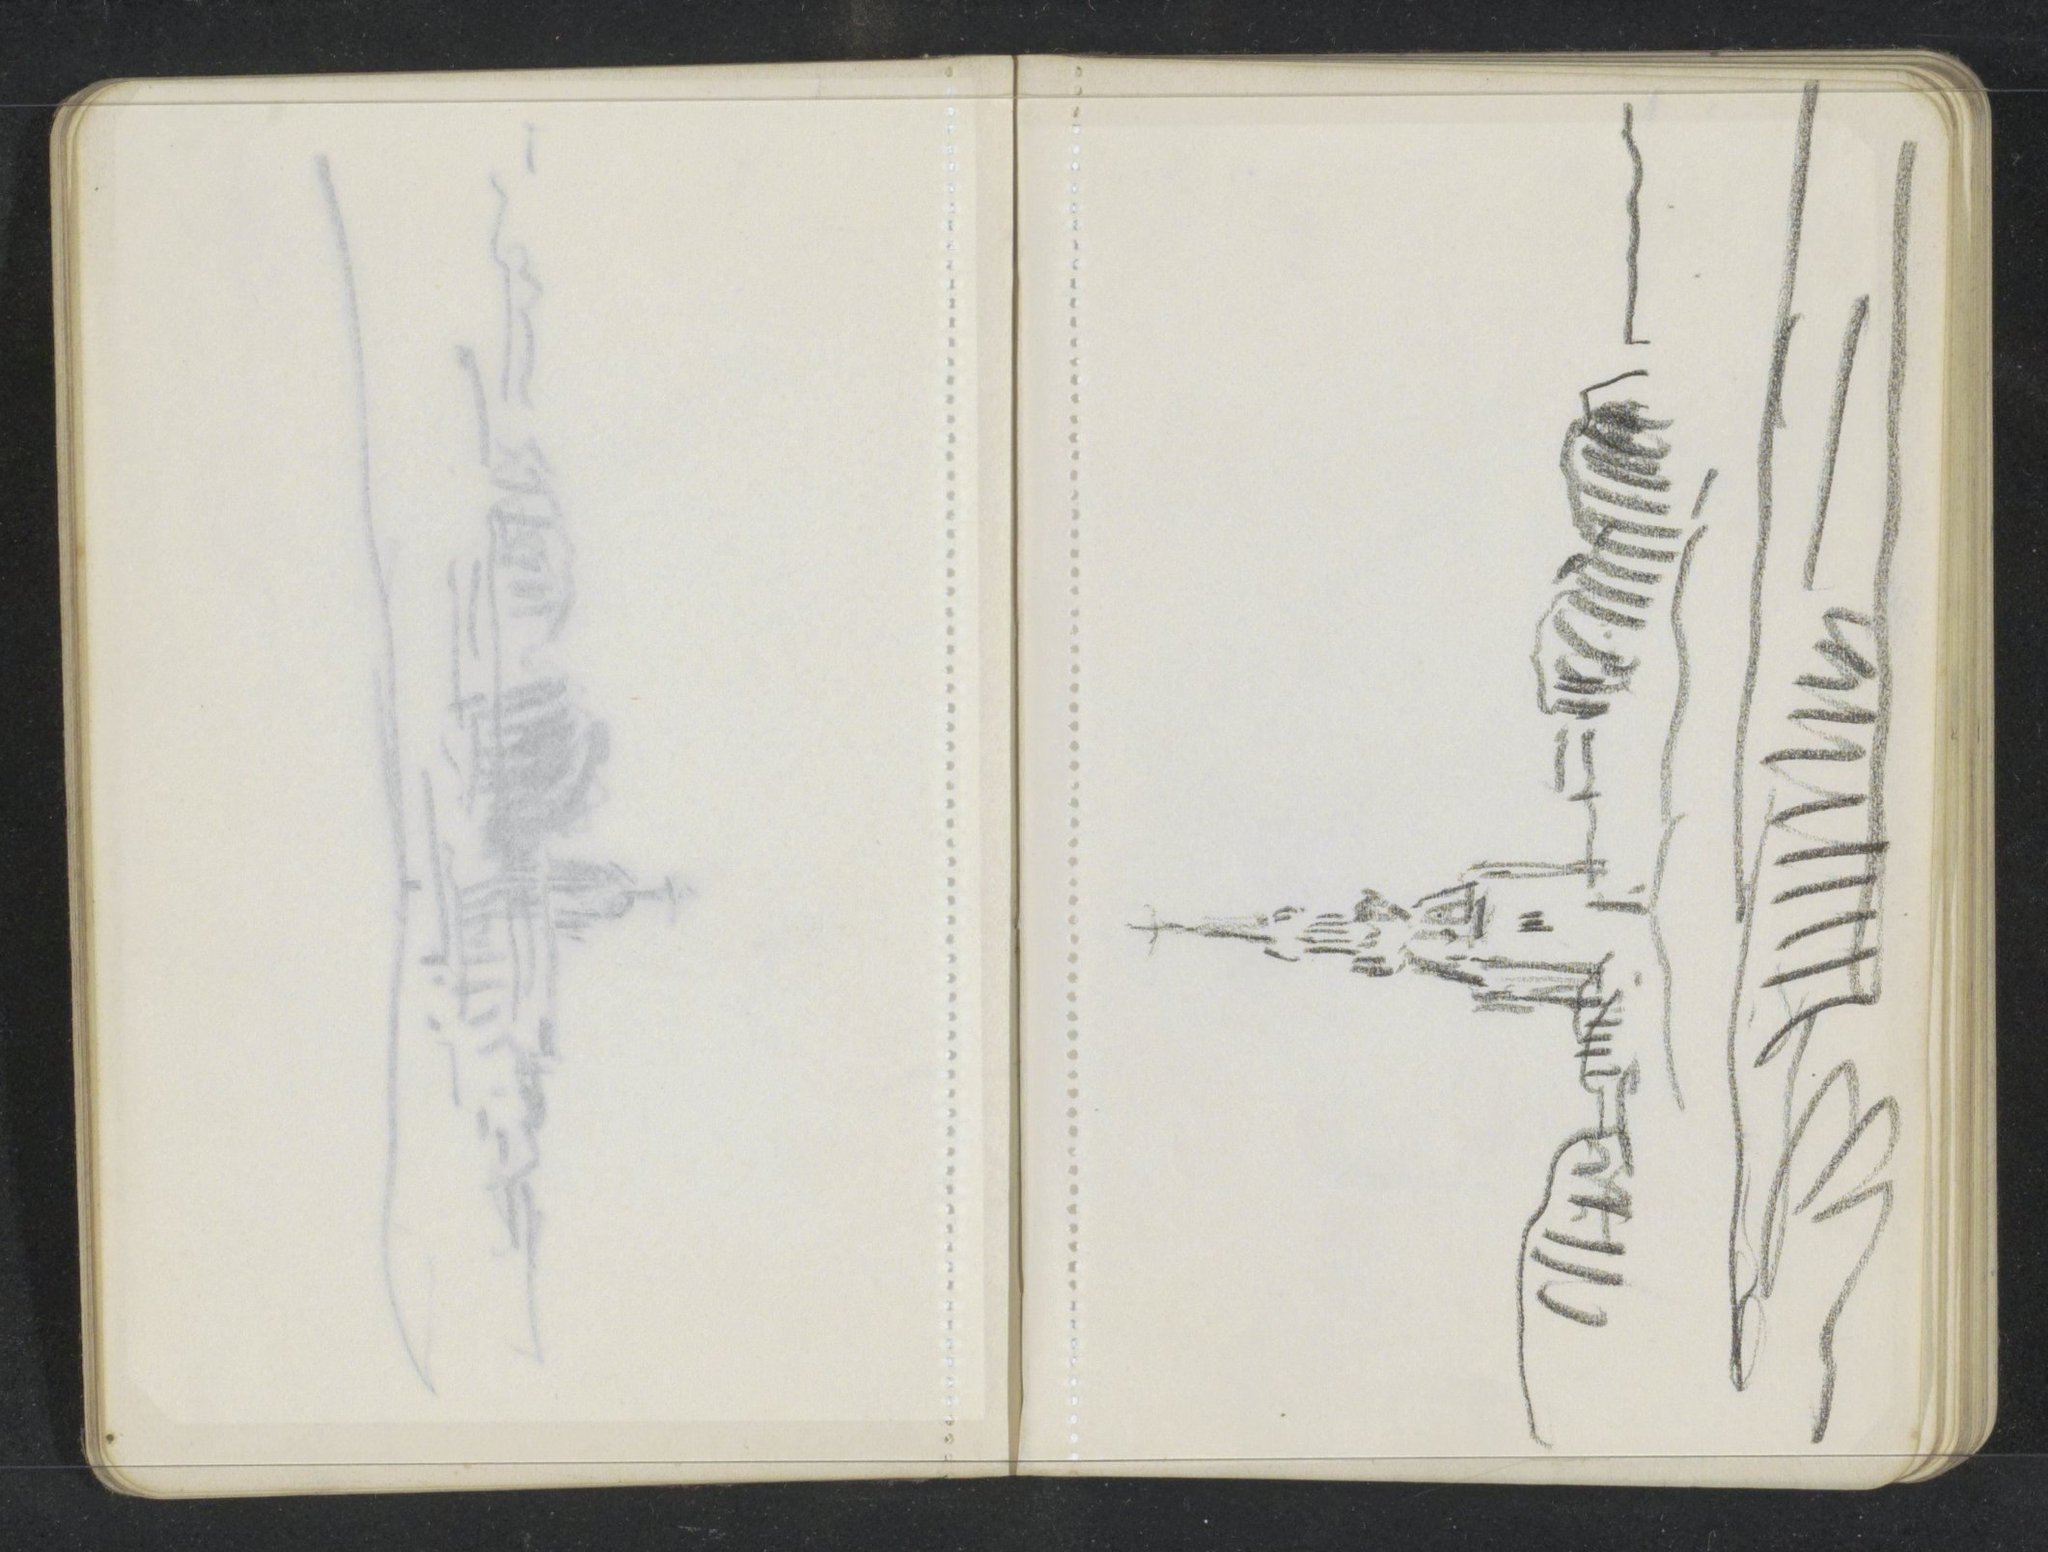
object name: sketchbook leaf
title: Landschap met een kerktoren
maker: alexander shilling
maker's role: draughtsman, print maker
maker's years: 1859-1937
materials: chalk, paper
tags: city-view, and landscape with man-made constructions, parts of church exterior and annexes: tower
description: Blad 15 recto uit een schetsboek met 91 bladen.